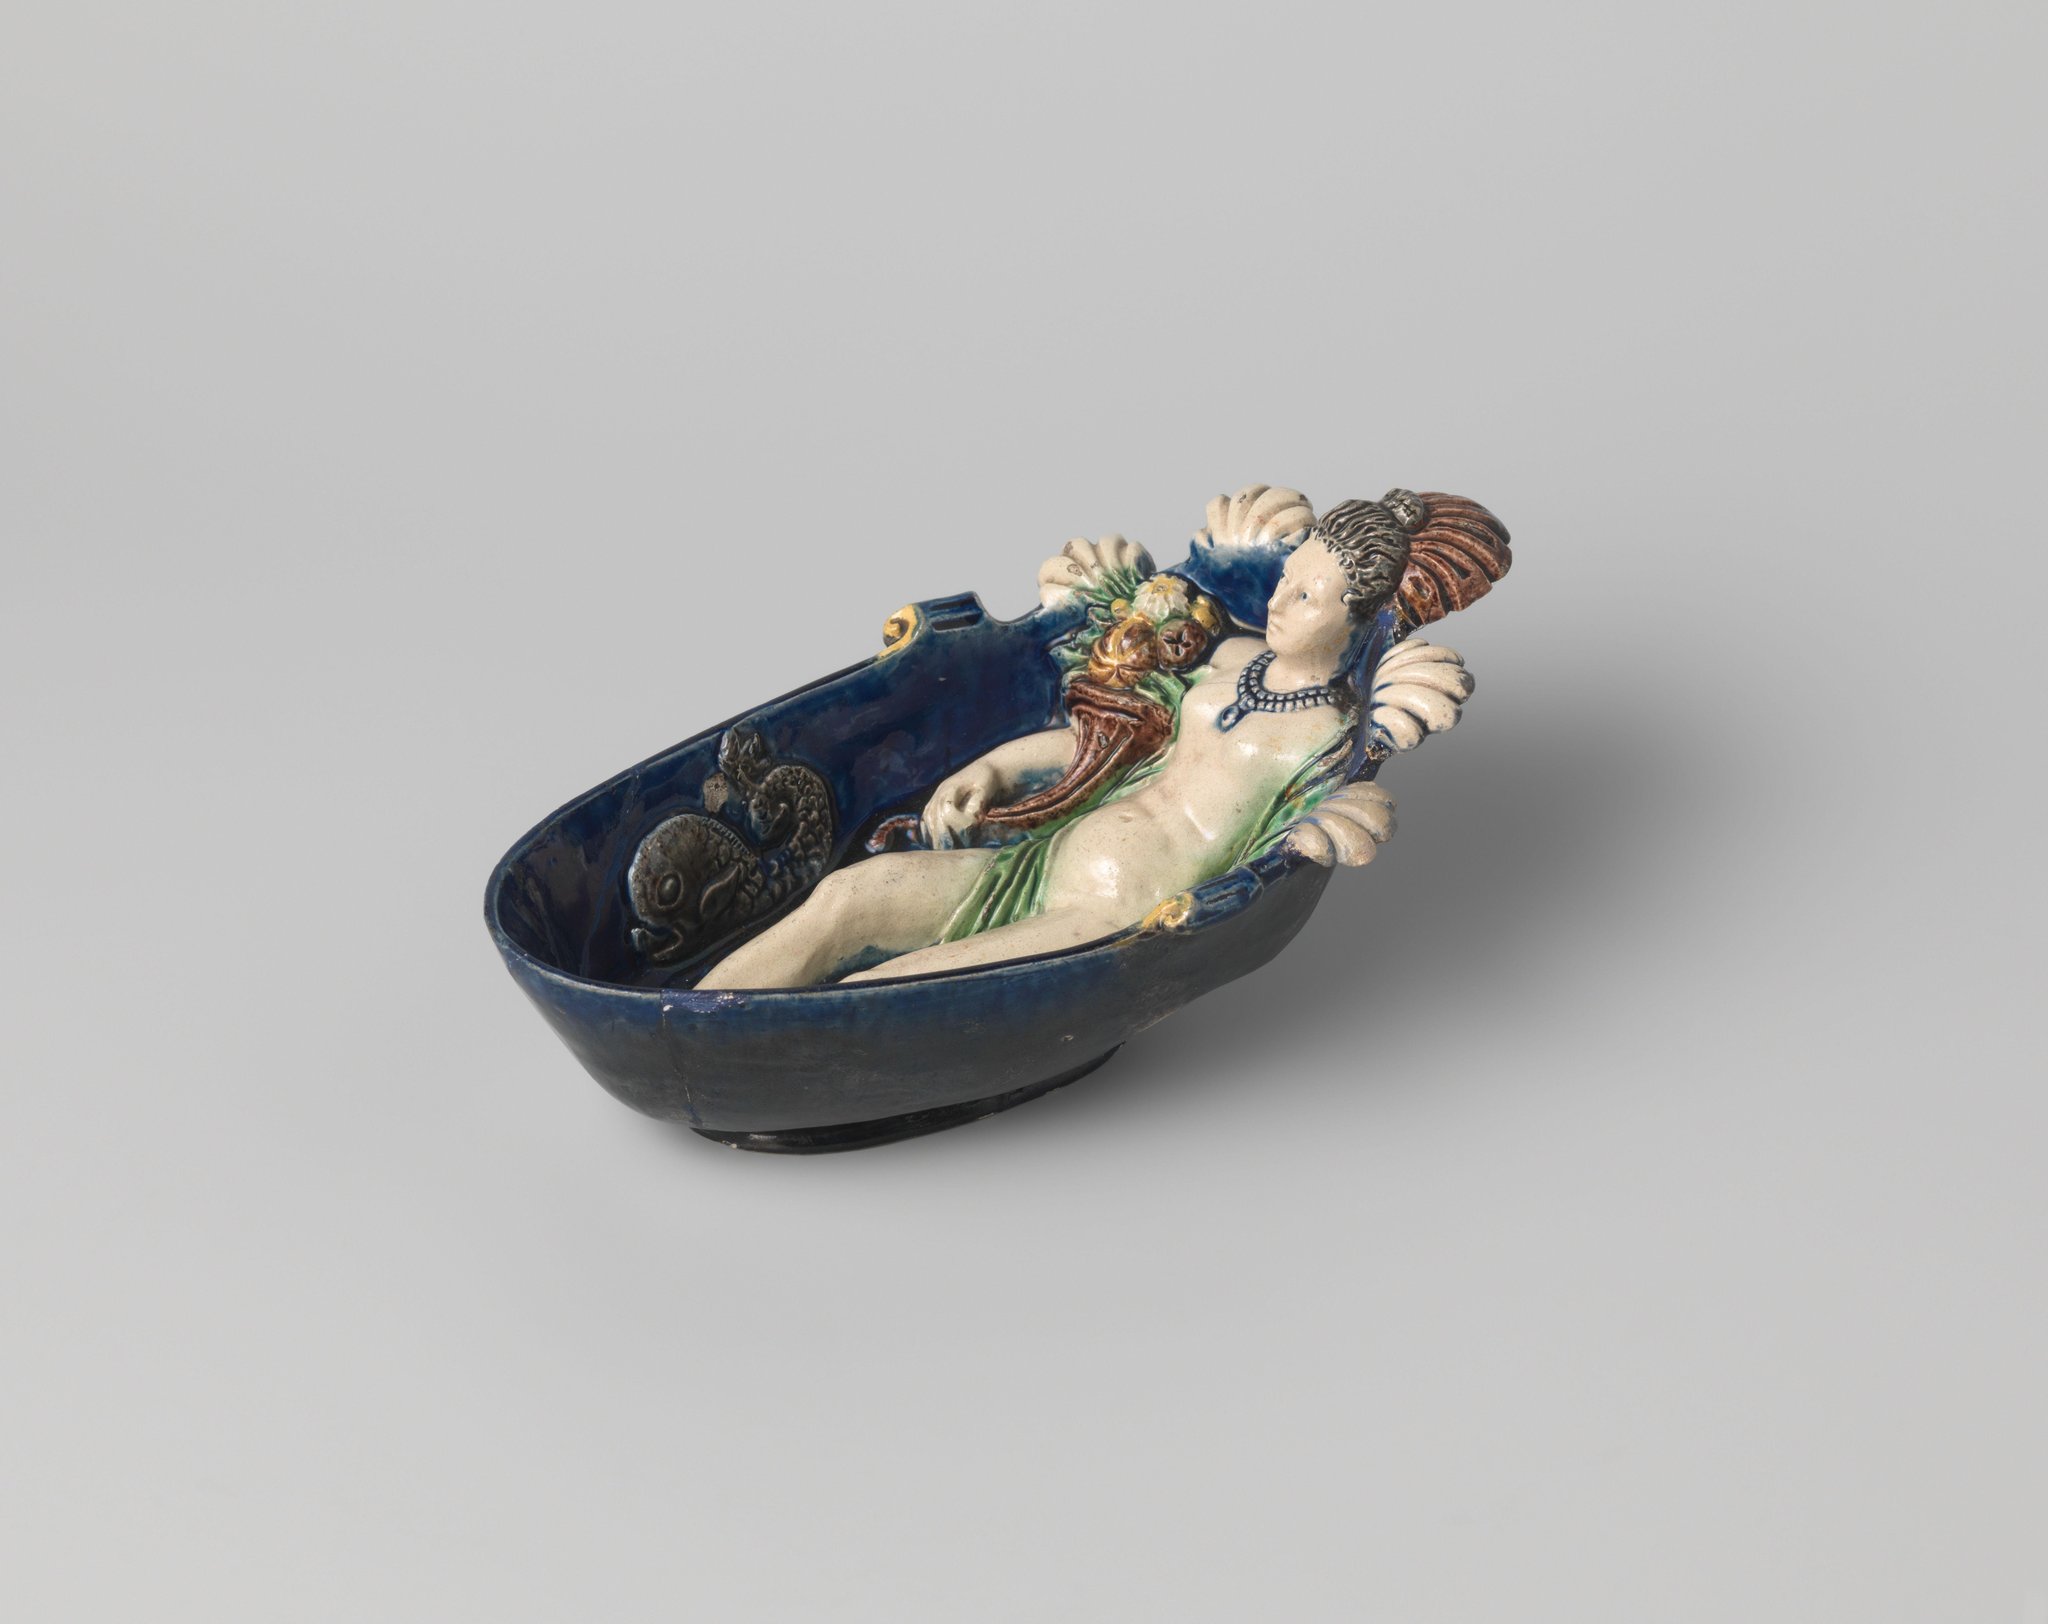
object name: dish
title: Schaal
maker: Anonymous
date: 1600-1635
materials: earthenware, glaze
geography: france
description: Ovale schaal van loodglazuuraardewerk. De schaal heeft de vorm van een badkuip. In het bad ligt een naakte vrouw (genre Palissy).